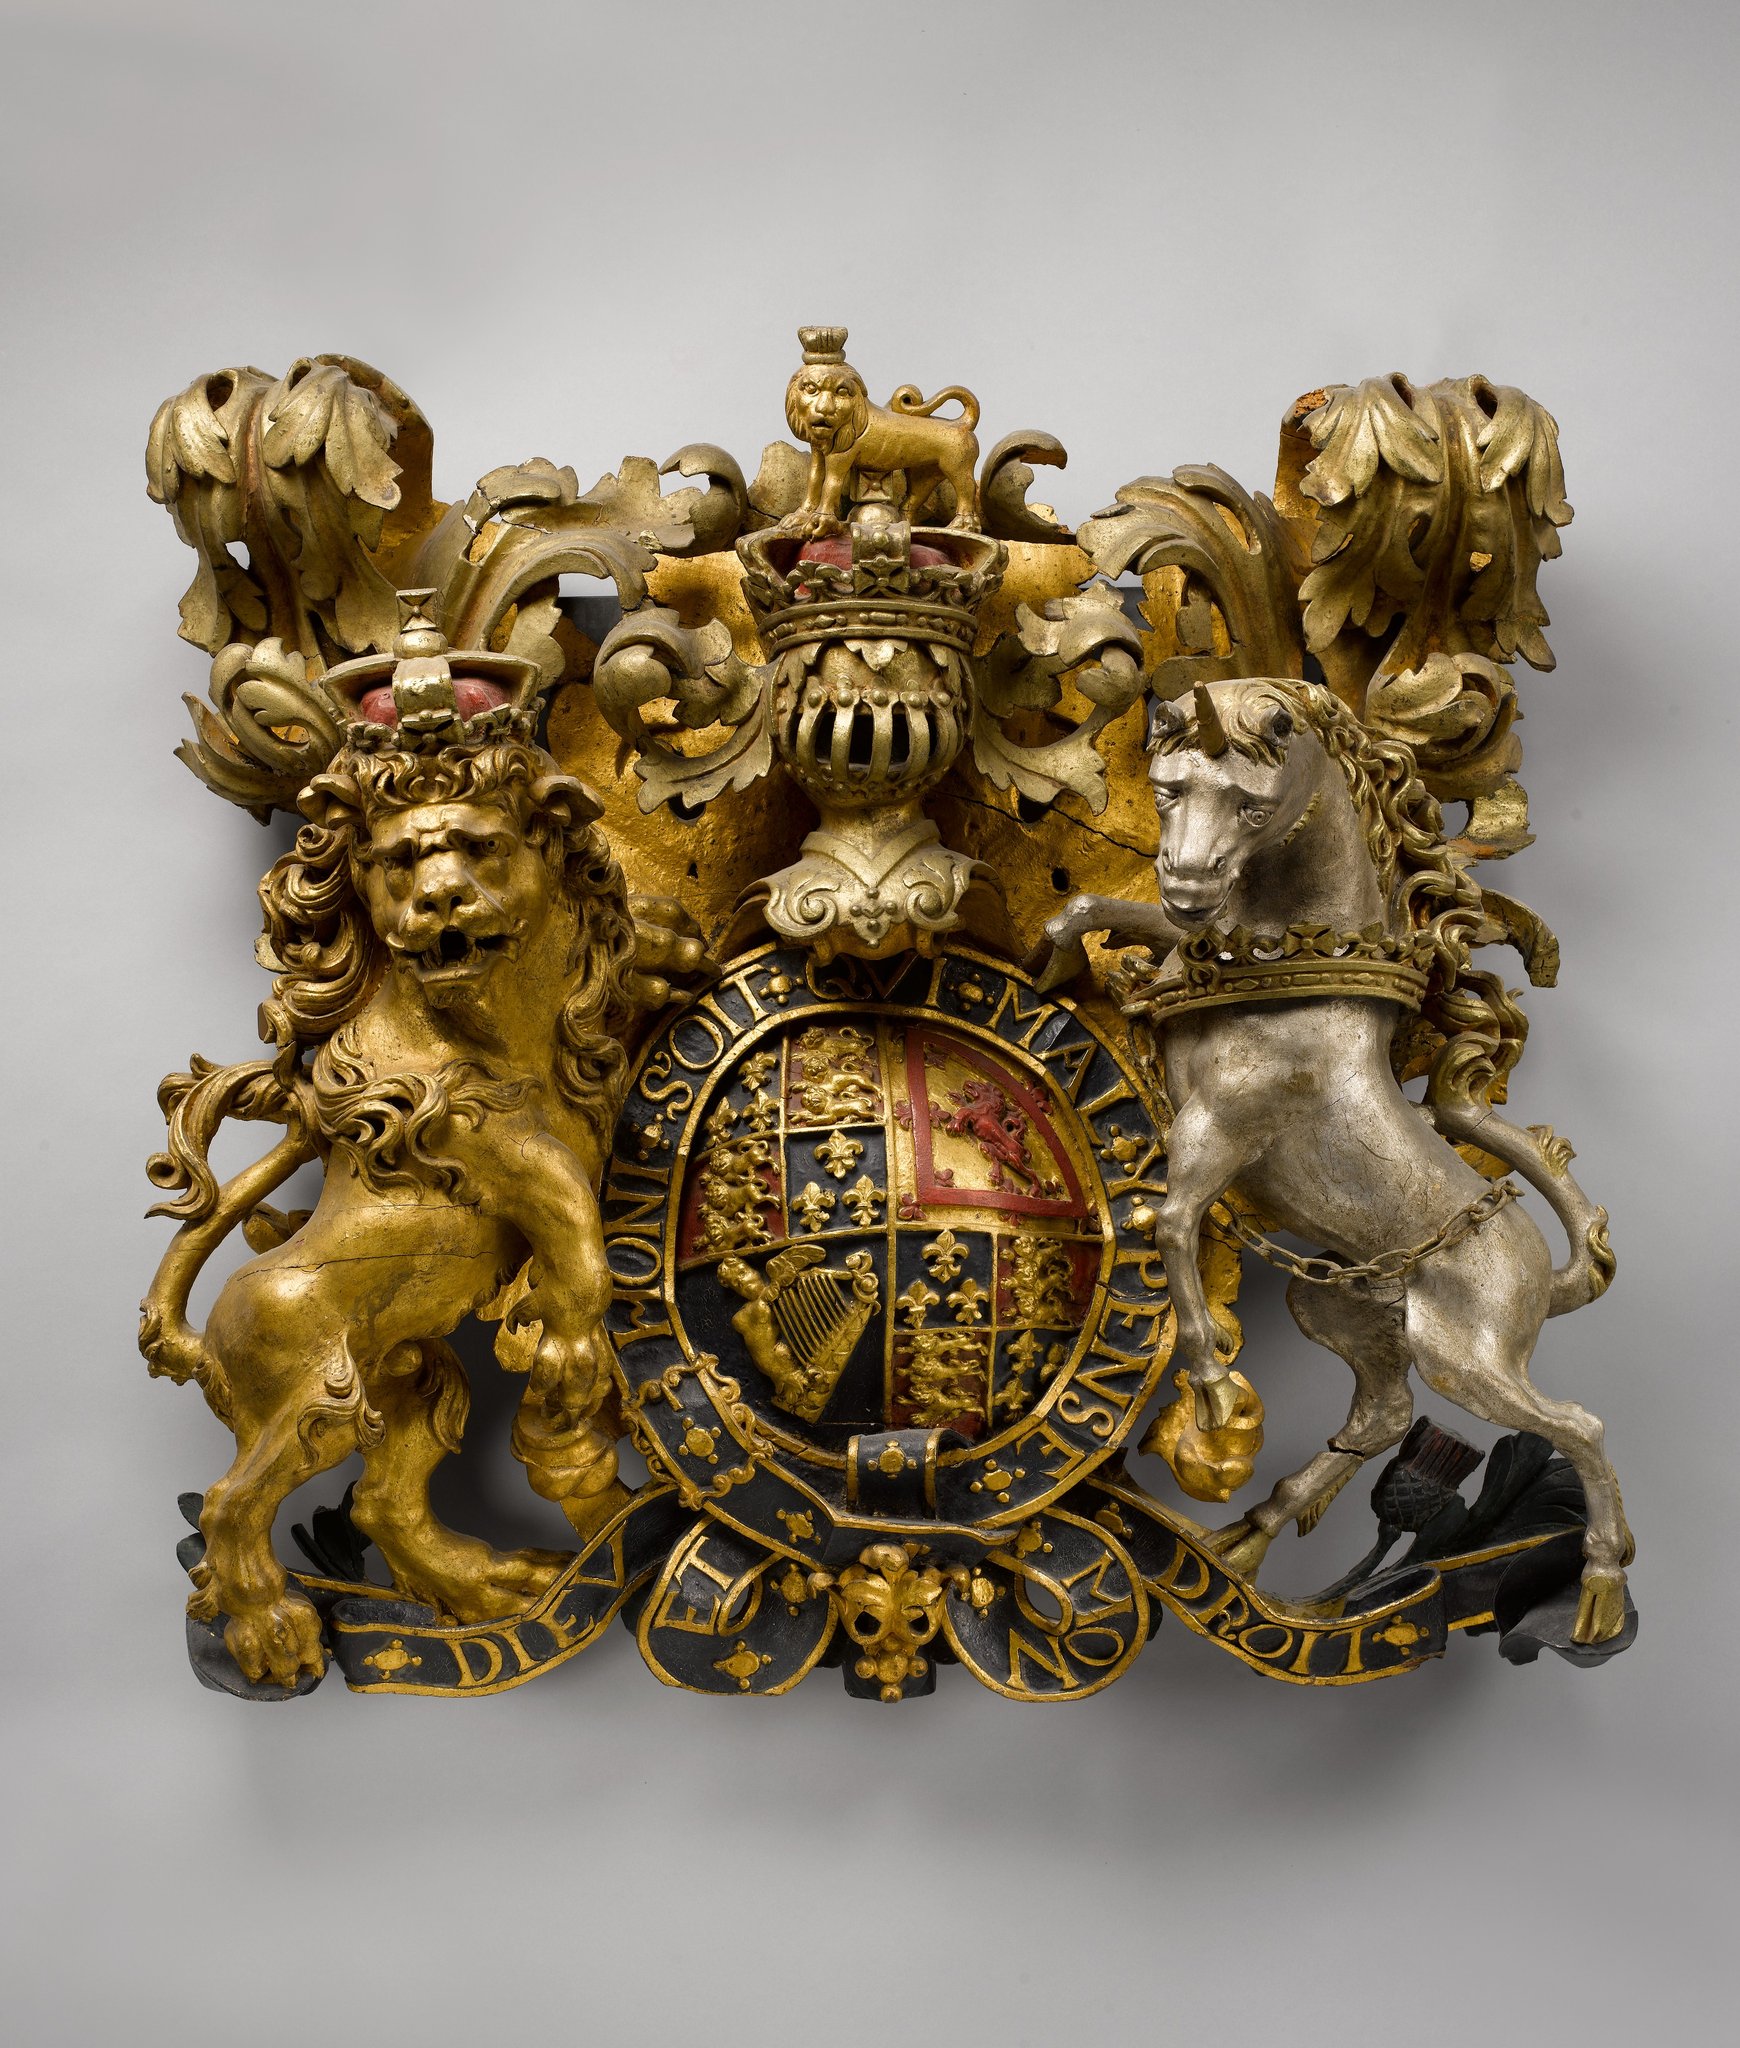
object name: armorial panel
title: Armorial panel with Stuart coat of arms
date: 1685-1688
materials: gilt, silver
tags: horses,lions,coat of arms